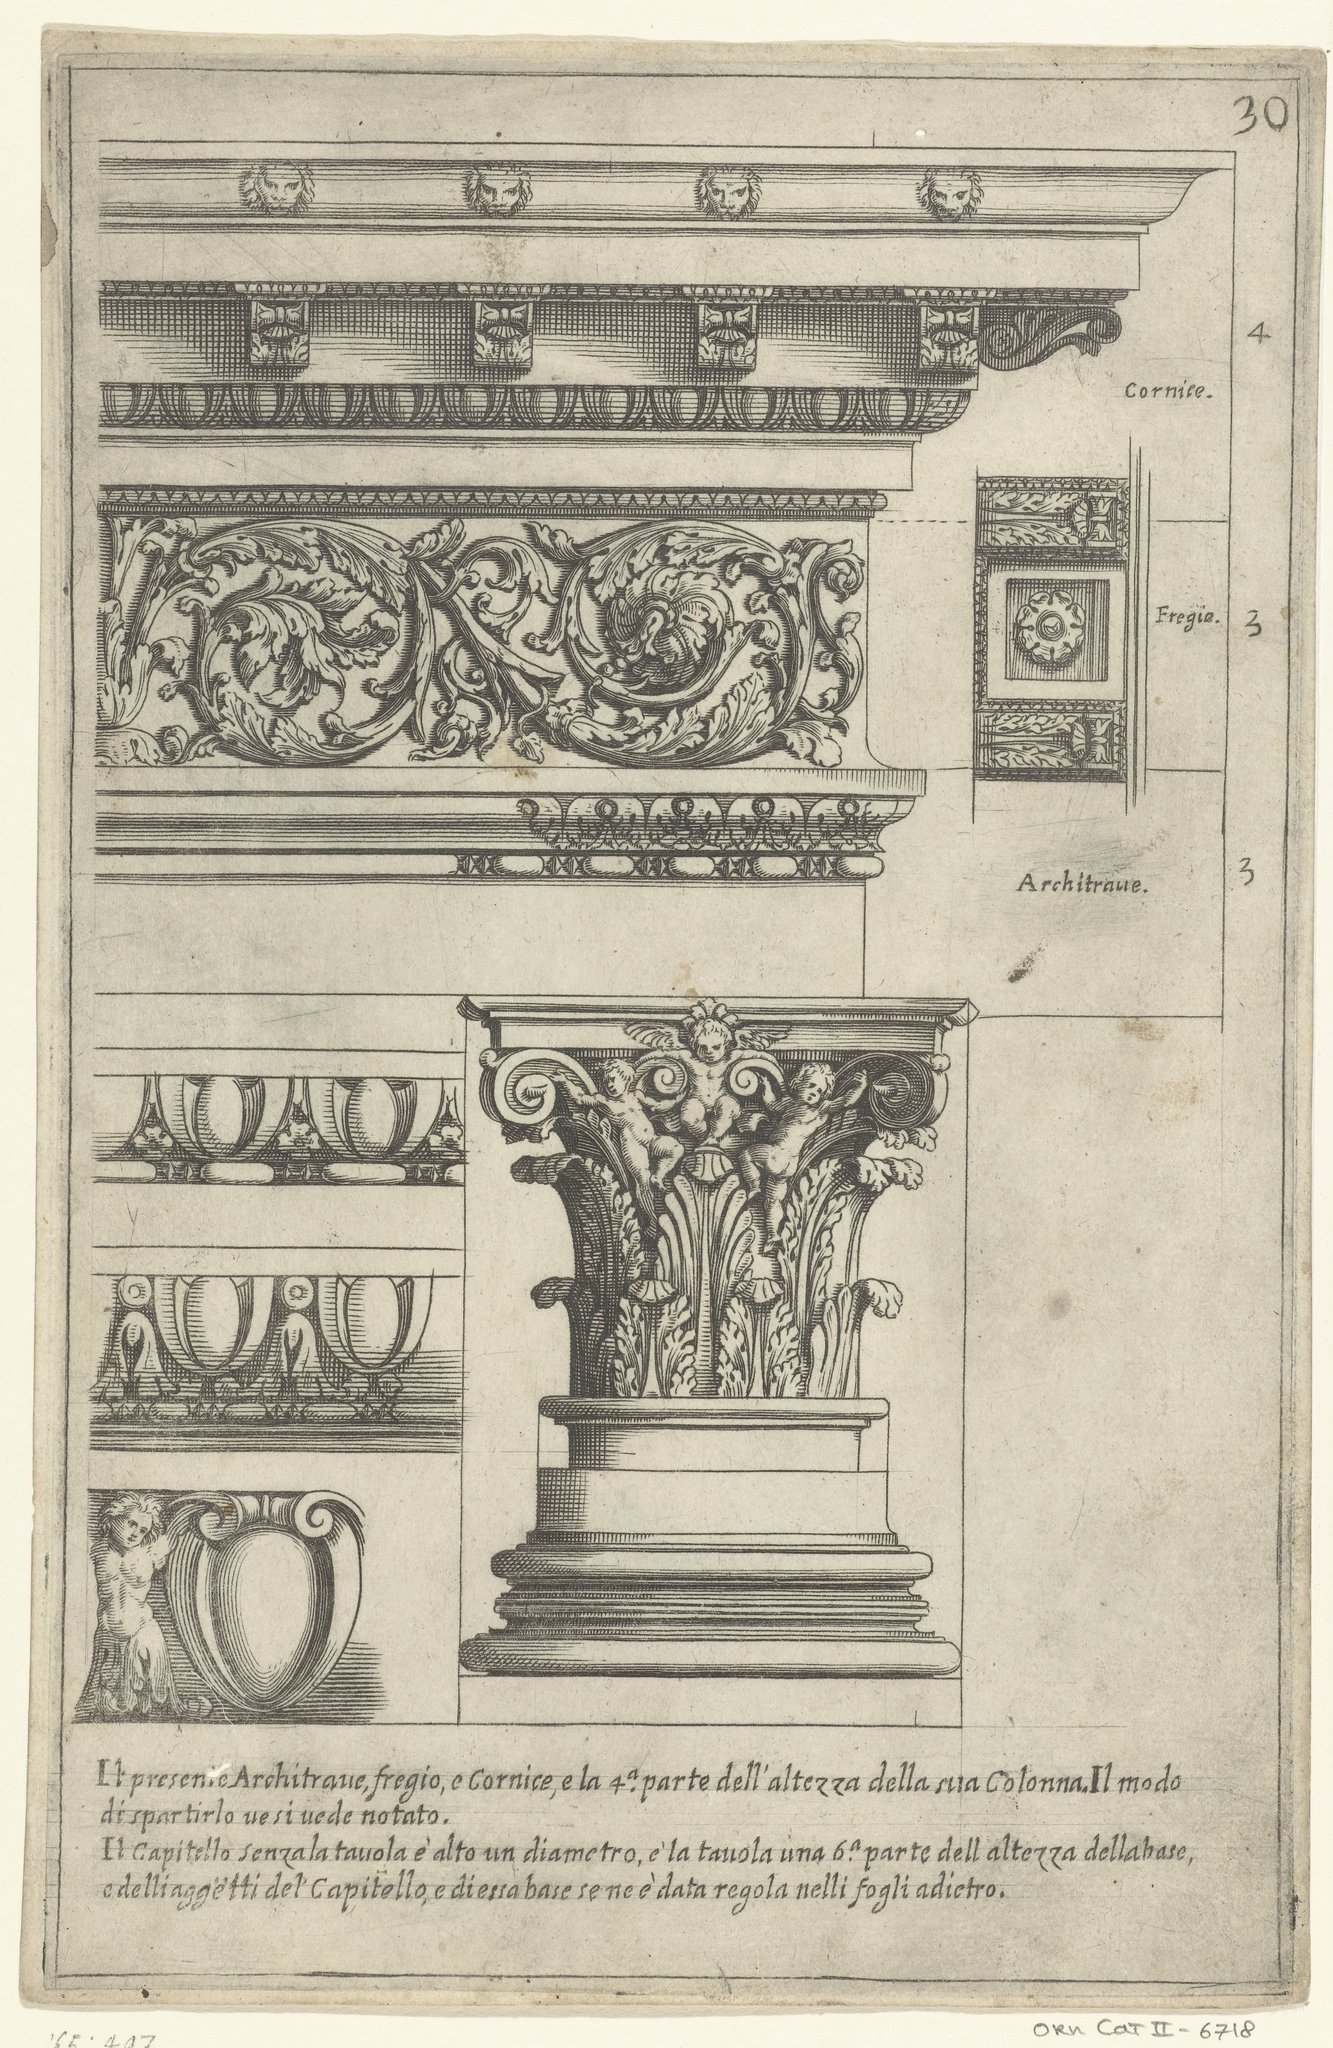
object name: ornament print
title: Korintisch hoofdgestel, kapiteel en basement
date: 1636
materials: paper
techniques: engraving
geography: italy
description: Met details van de kroonlijst. Onderaan staat uitleg.